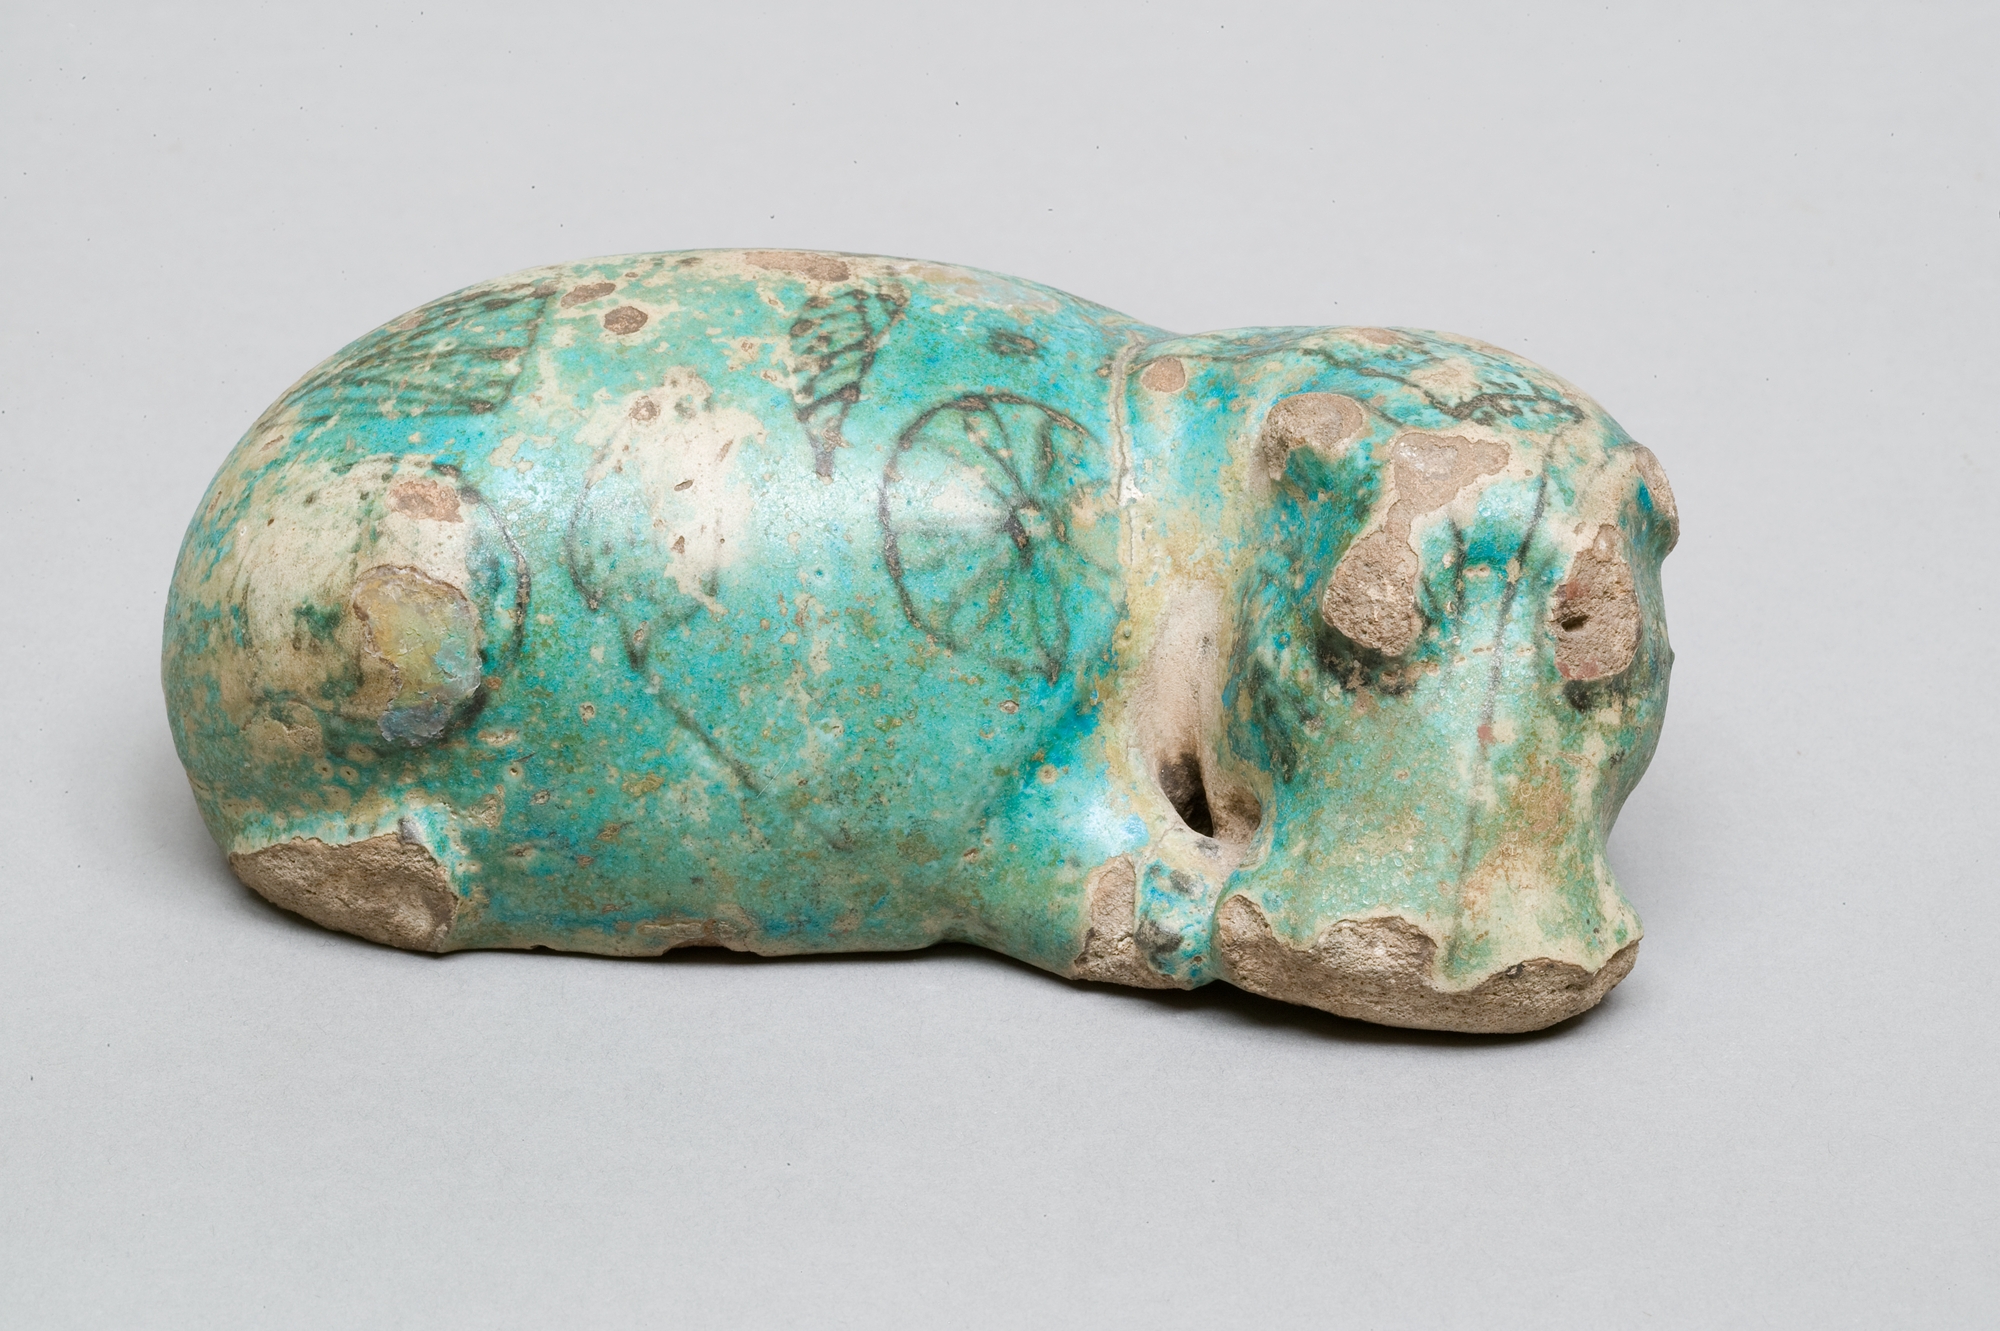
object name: figurine, hippopotamus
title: Hippopotamus figurine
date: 1981-1550 BCE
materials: faience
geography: egypt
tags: hippos